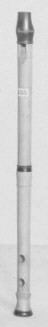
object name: tabor pipe in f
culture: french or british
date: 1801-1900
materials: horn, wood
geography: france or england